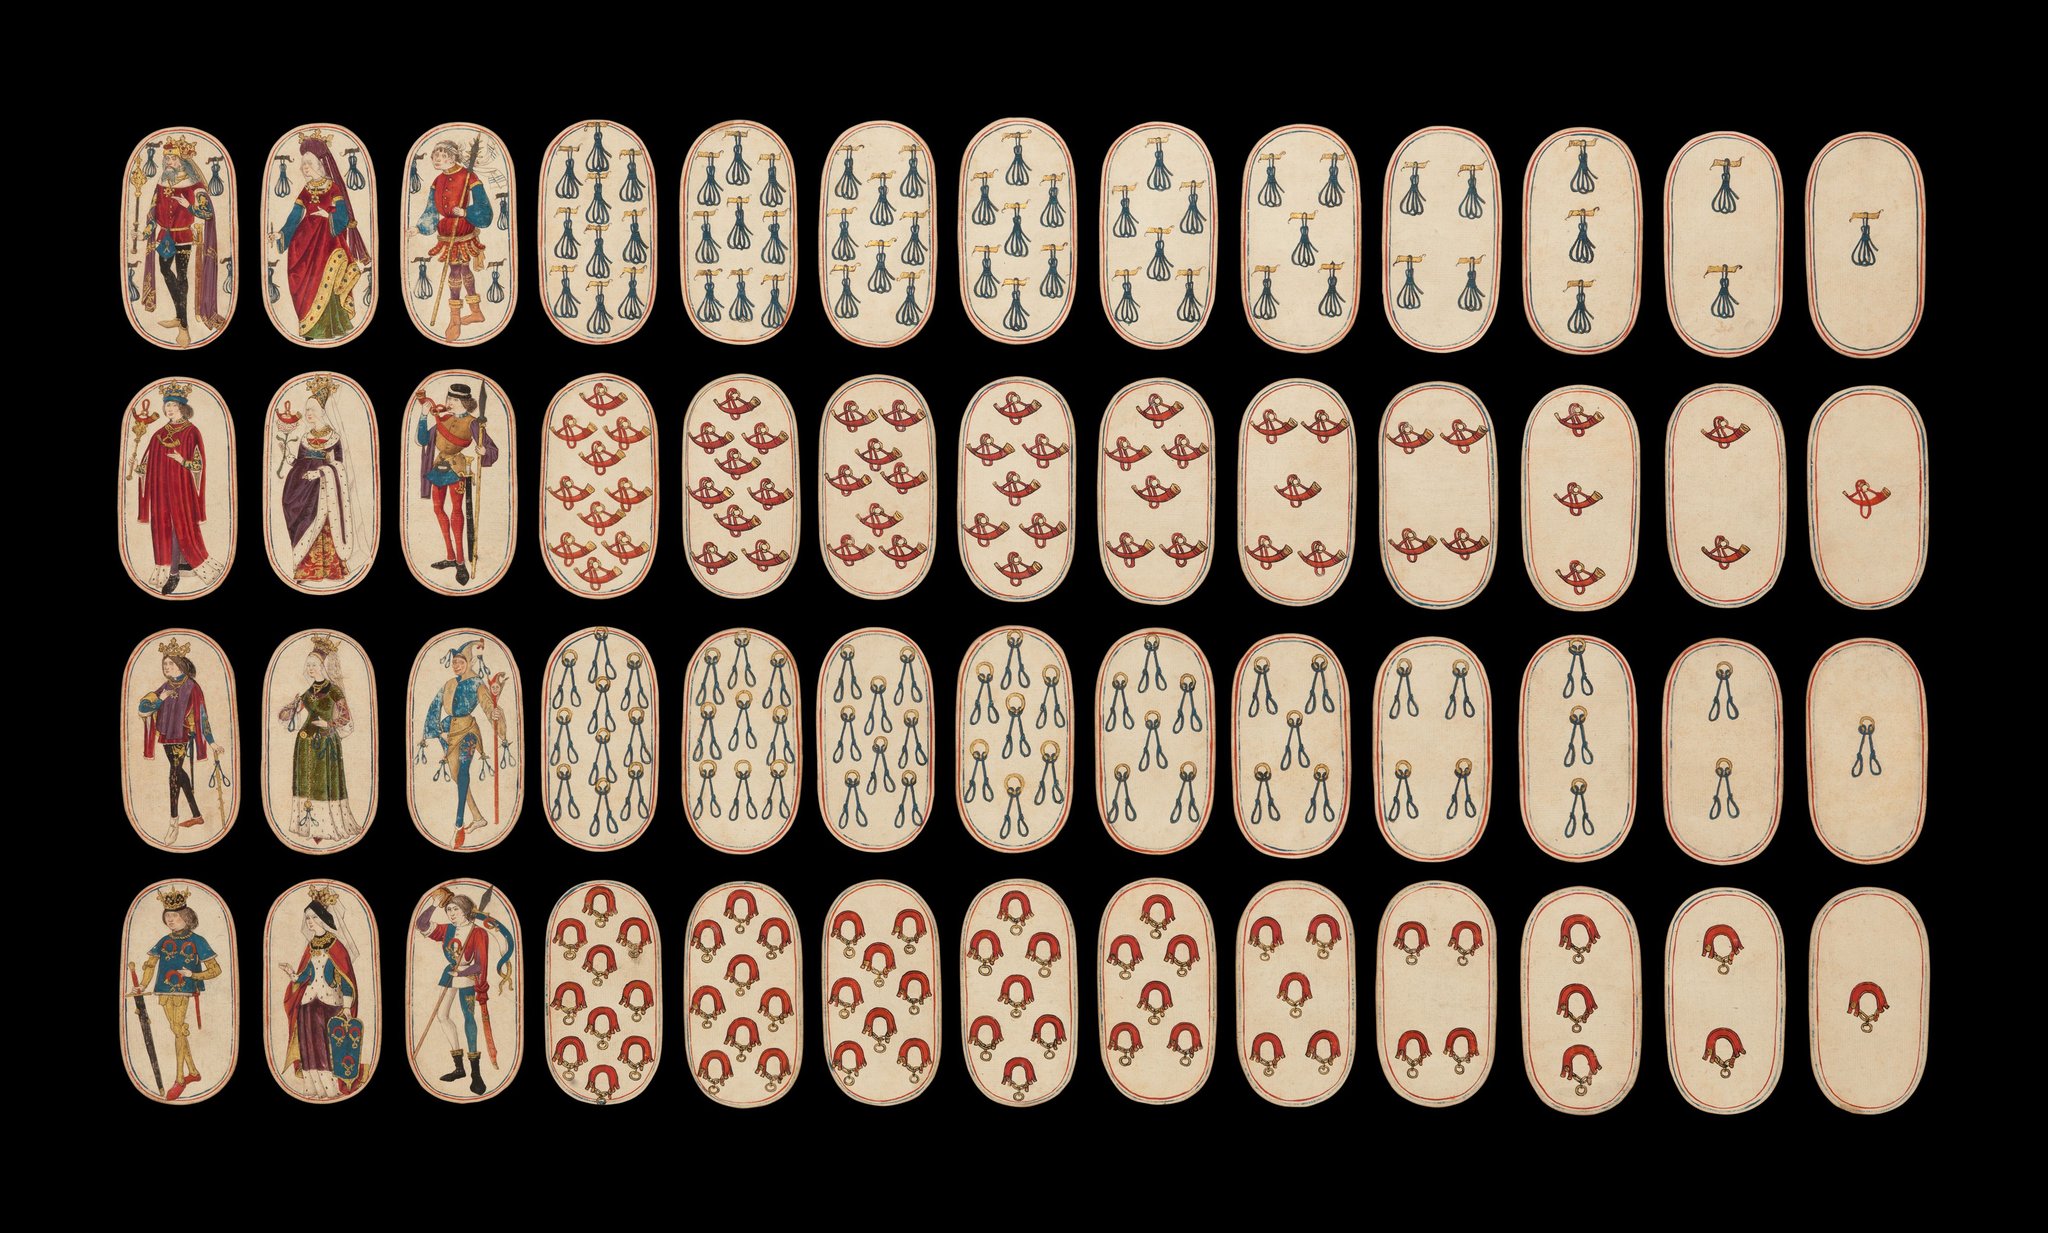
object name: playing card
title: The Cloisters Playing Cards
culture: south netherlandish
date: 1475-1480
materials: glaze, gold, ink, paint, paper, silver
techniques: pen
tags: men,women,playing cards,horns,games